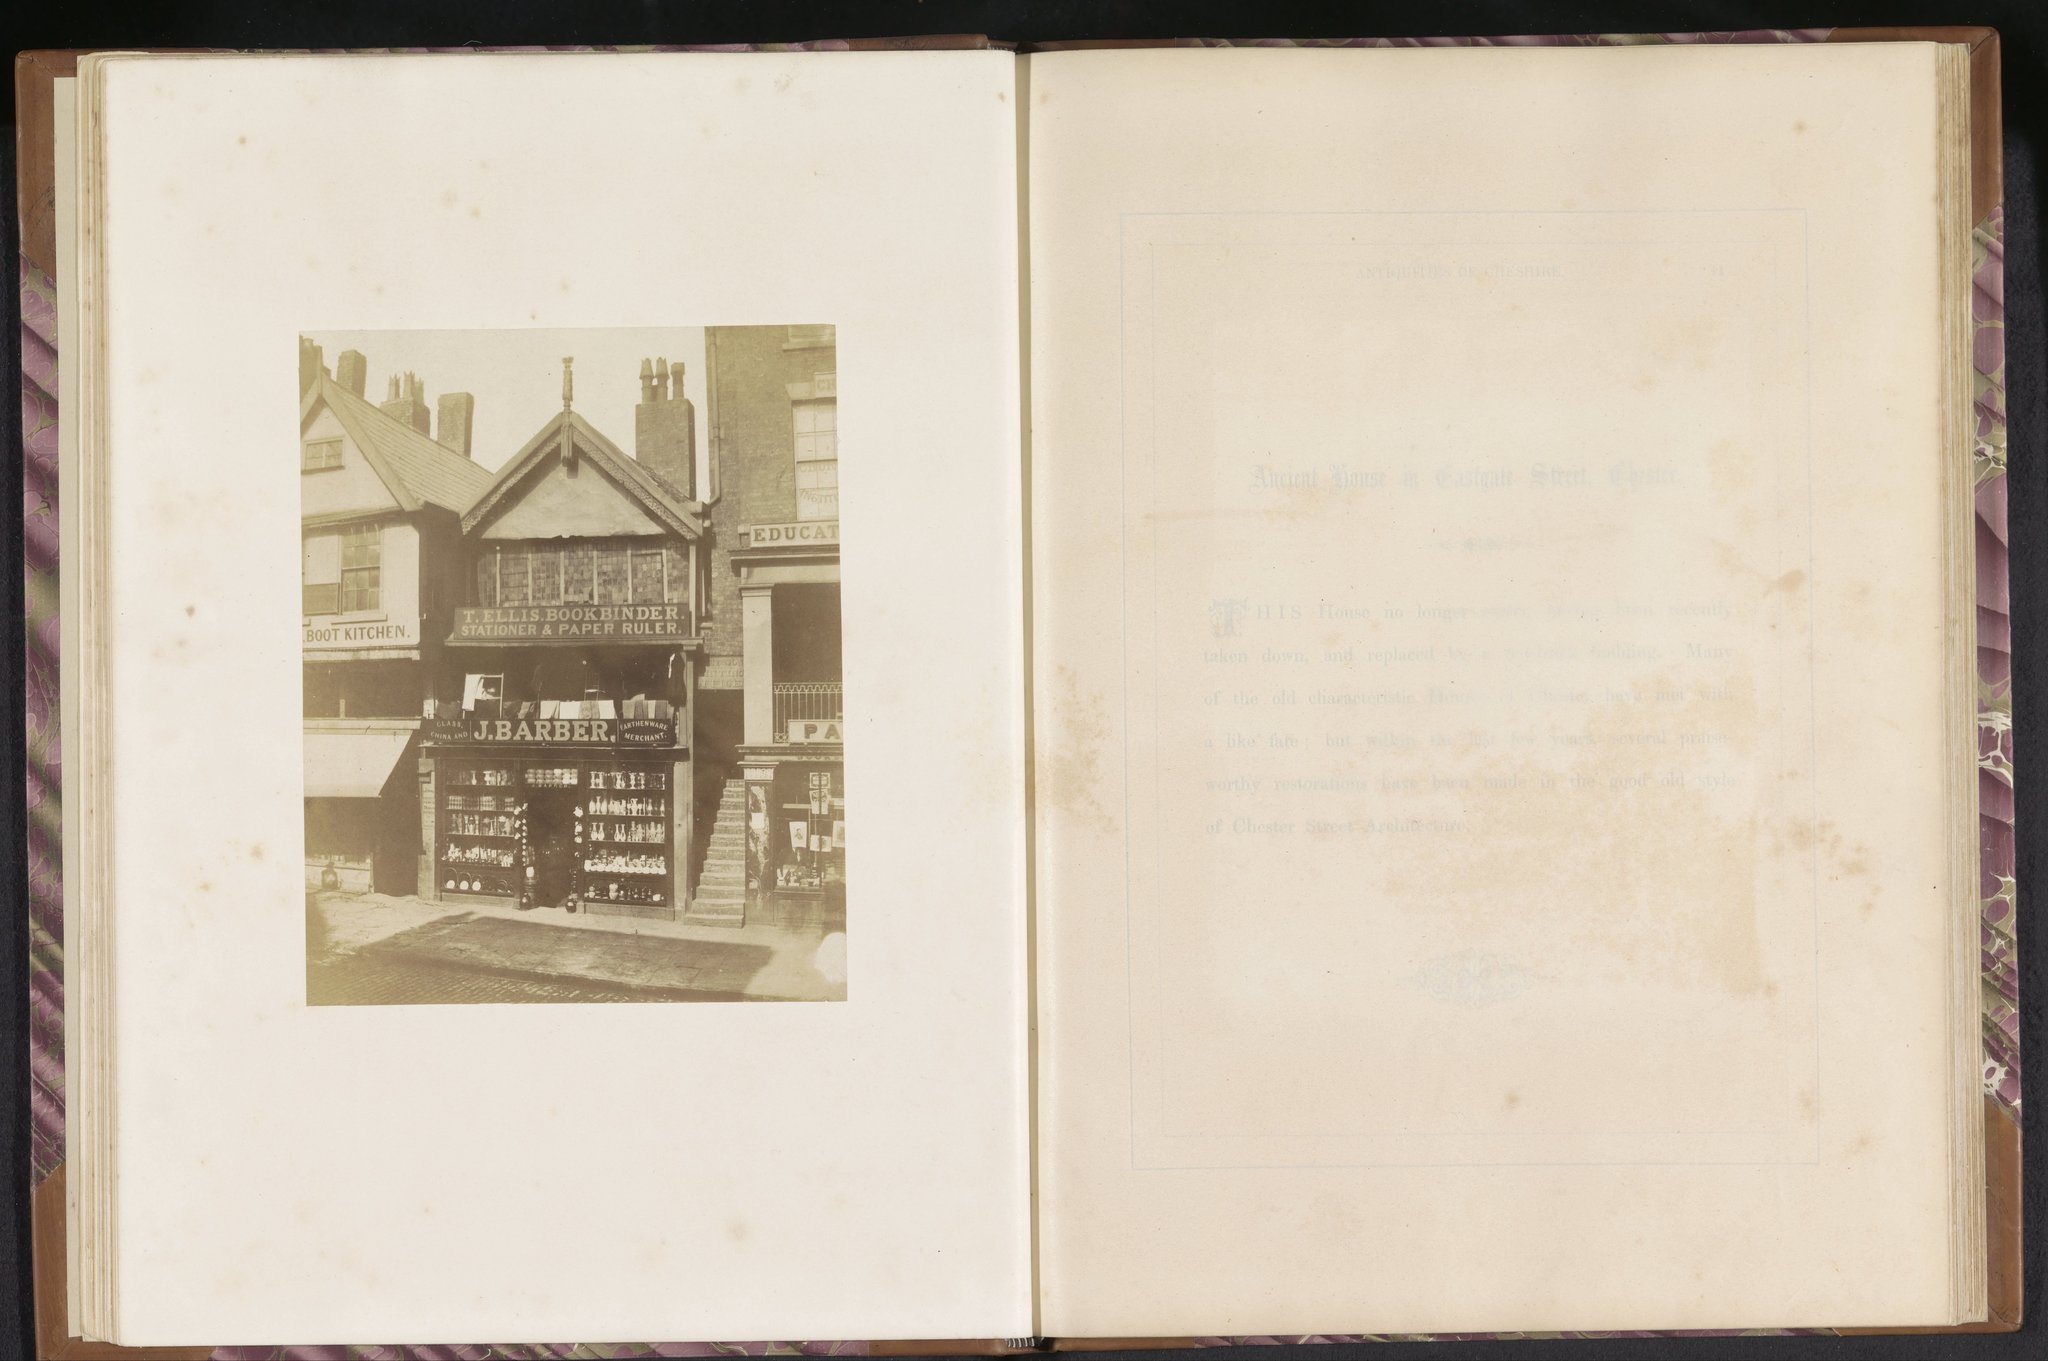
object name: photograph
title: Gezicht op een winkel in Eastgate Street in Chester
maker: william bryans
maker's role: fotograaf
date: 1850-1858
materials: photographic support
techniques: albumen print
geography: chester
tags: shop, store, village street, advertisement, notice